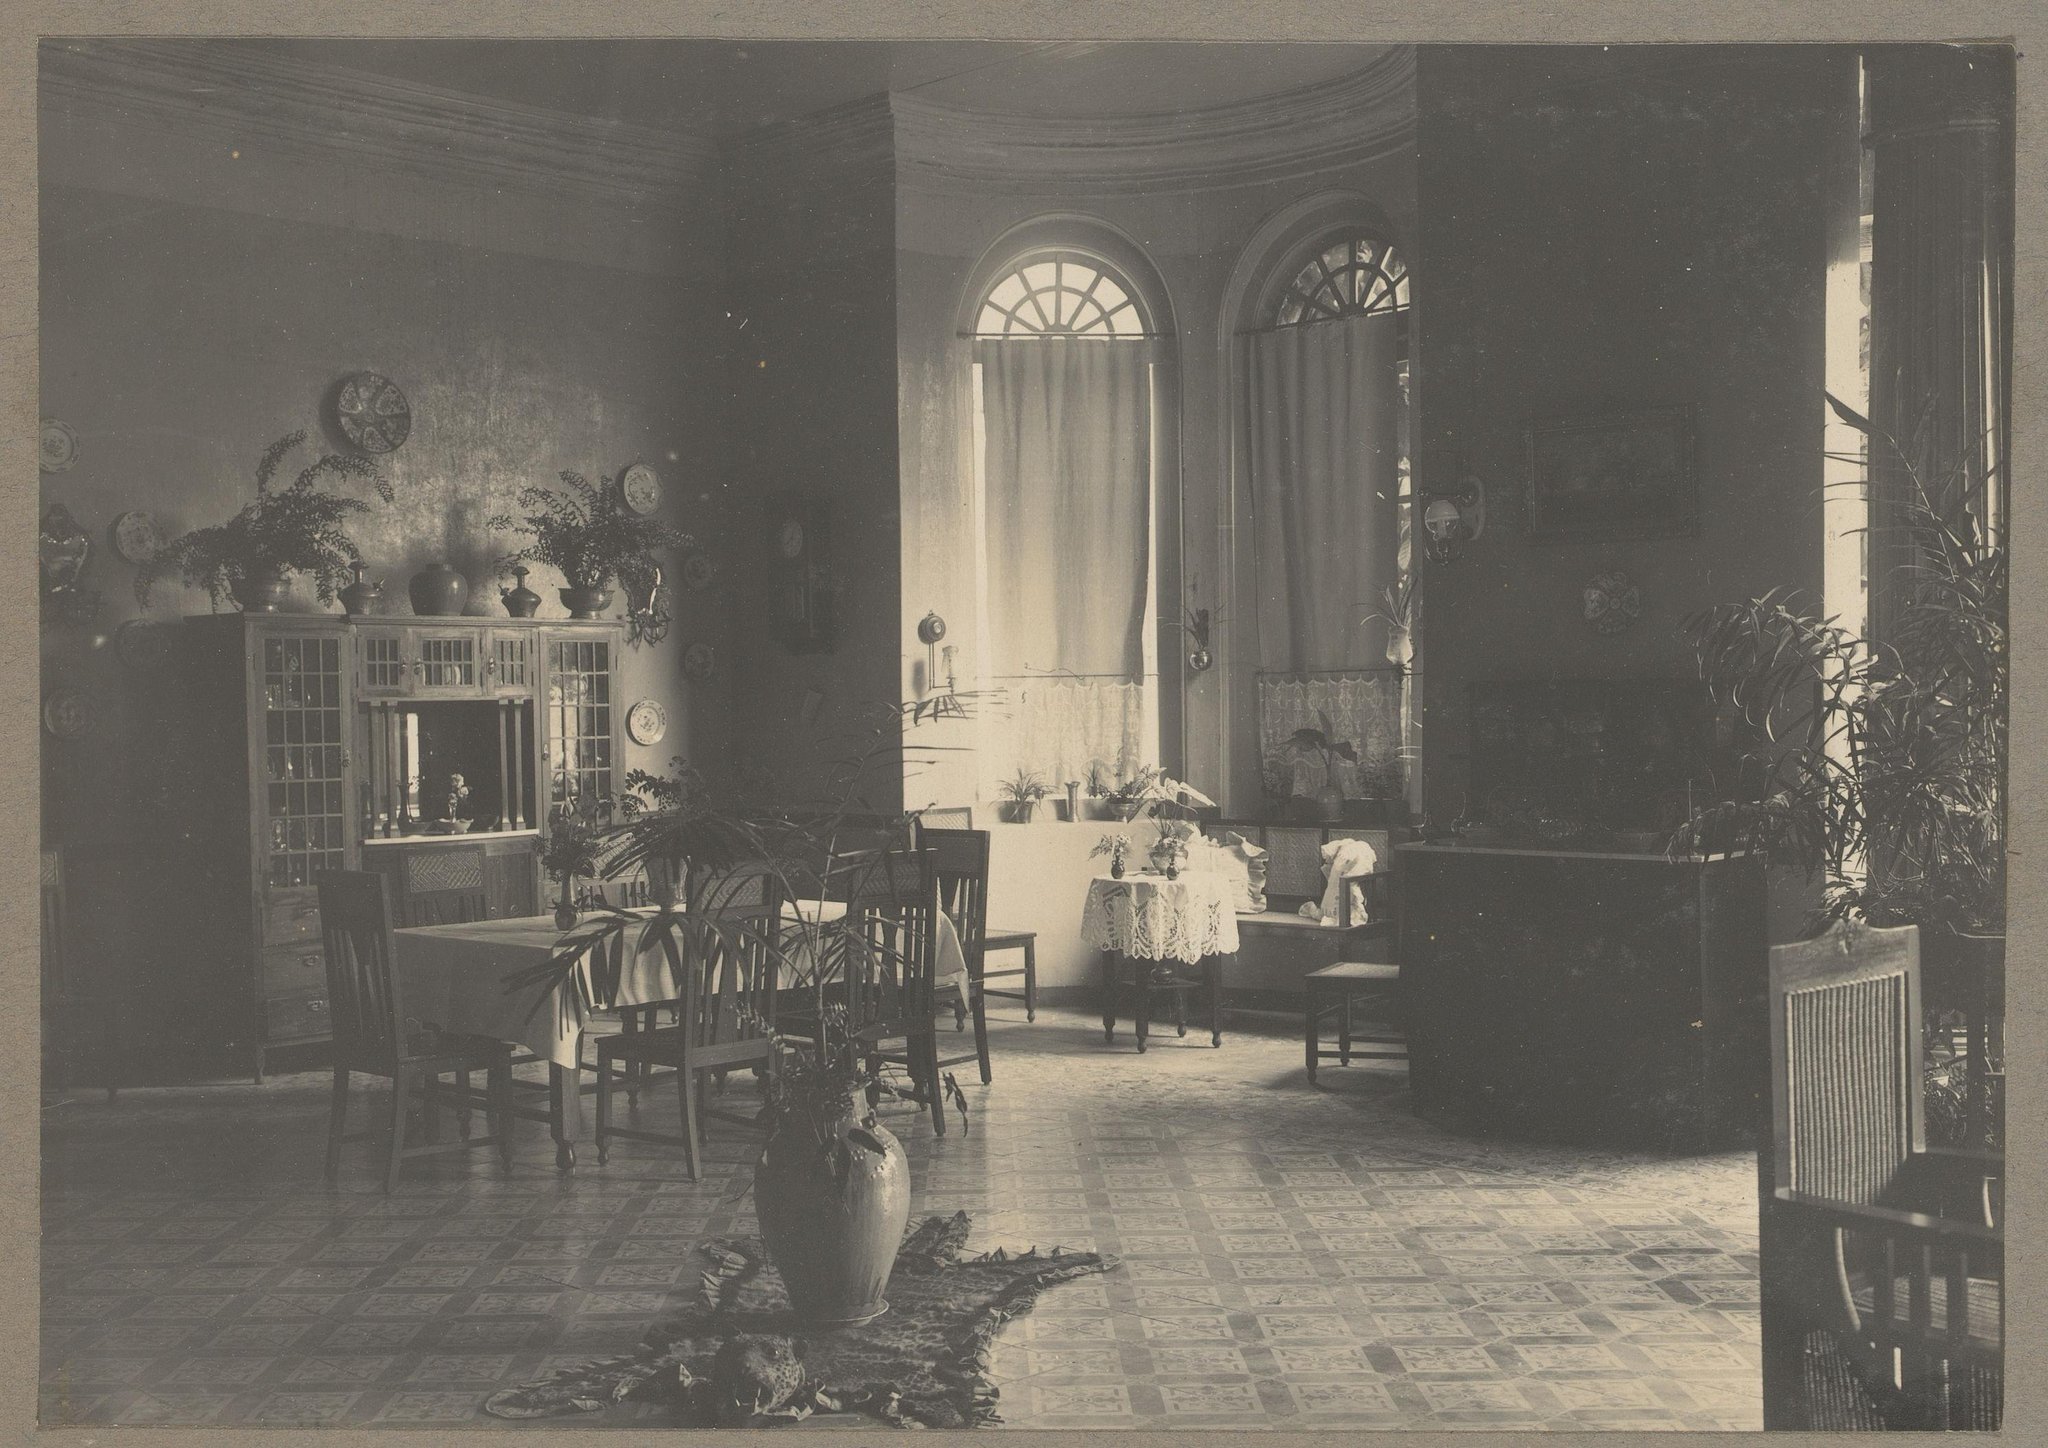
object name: photograph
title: Pangkalpinang Woning van den Resident (Interieur)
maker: Anonymous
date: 1914-1919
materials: photographic support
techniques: gelatin silver print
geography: bangka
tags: robert julius boers, colonial system, colonial governor, mining, interior of the house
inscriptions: inscription: ‘Pangkalpinang Woning van den Resident (Interieur)’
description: Interieur van de woning van de resident in Pangkalpinang. Onderdeel van het fotoalbum aangeboden aan Robert Julius Boers bij zijn vertrek naar Nederland in 1919 door het personeel van de Banka-tinwinning.